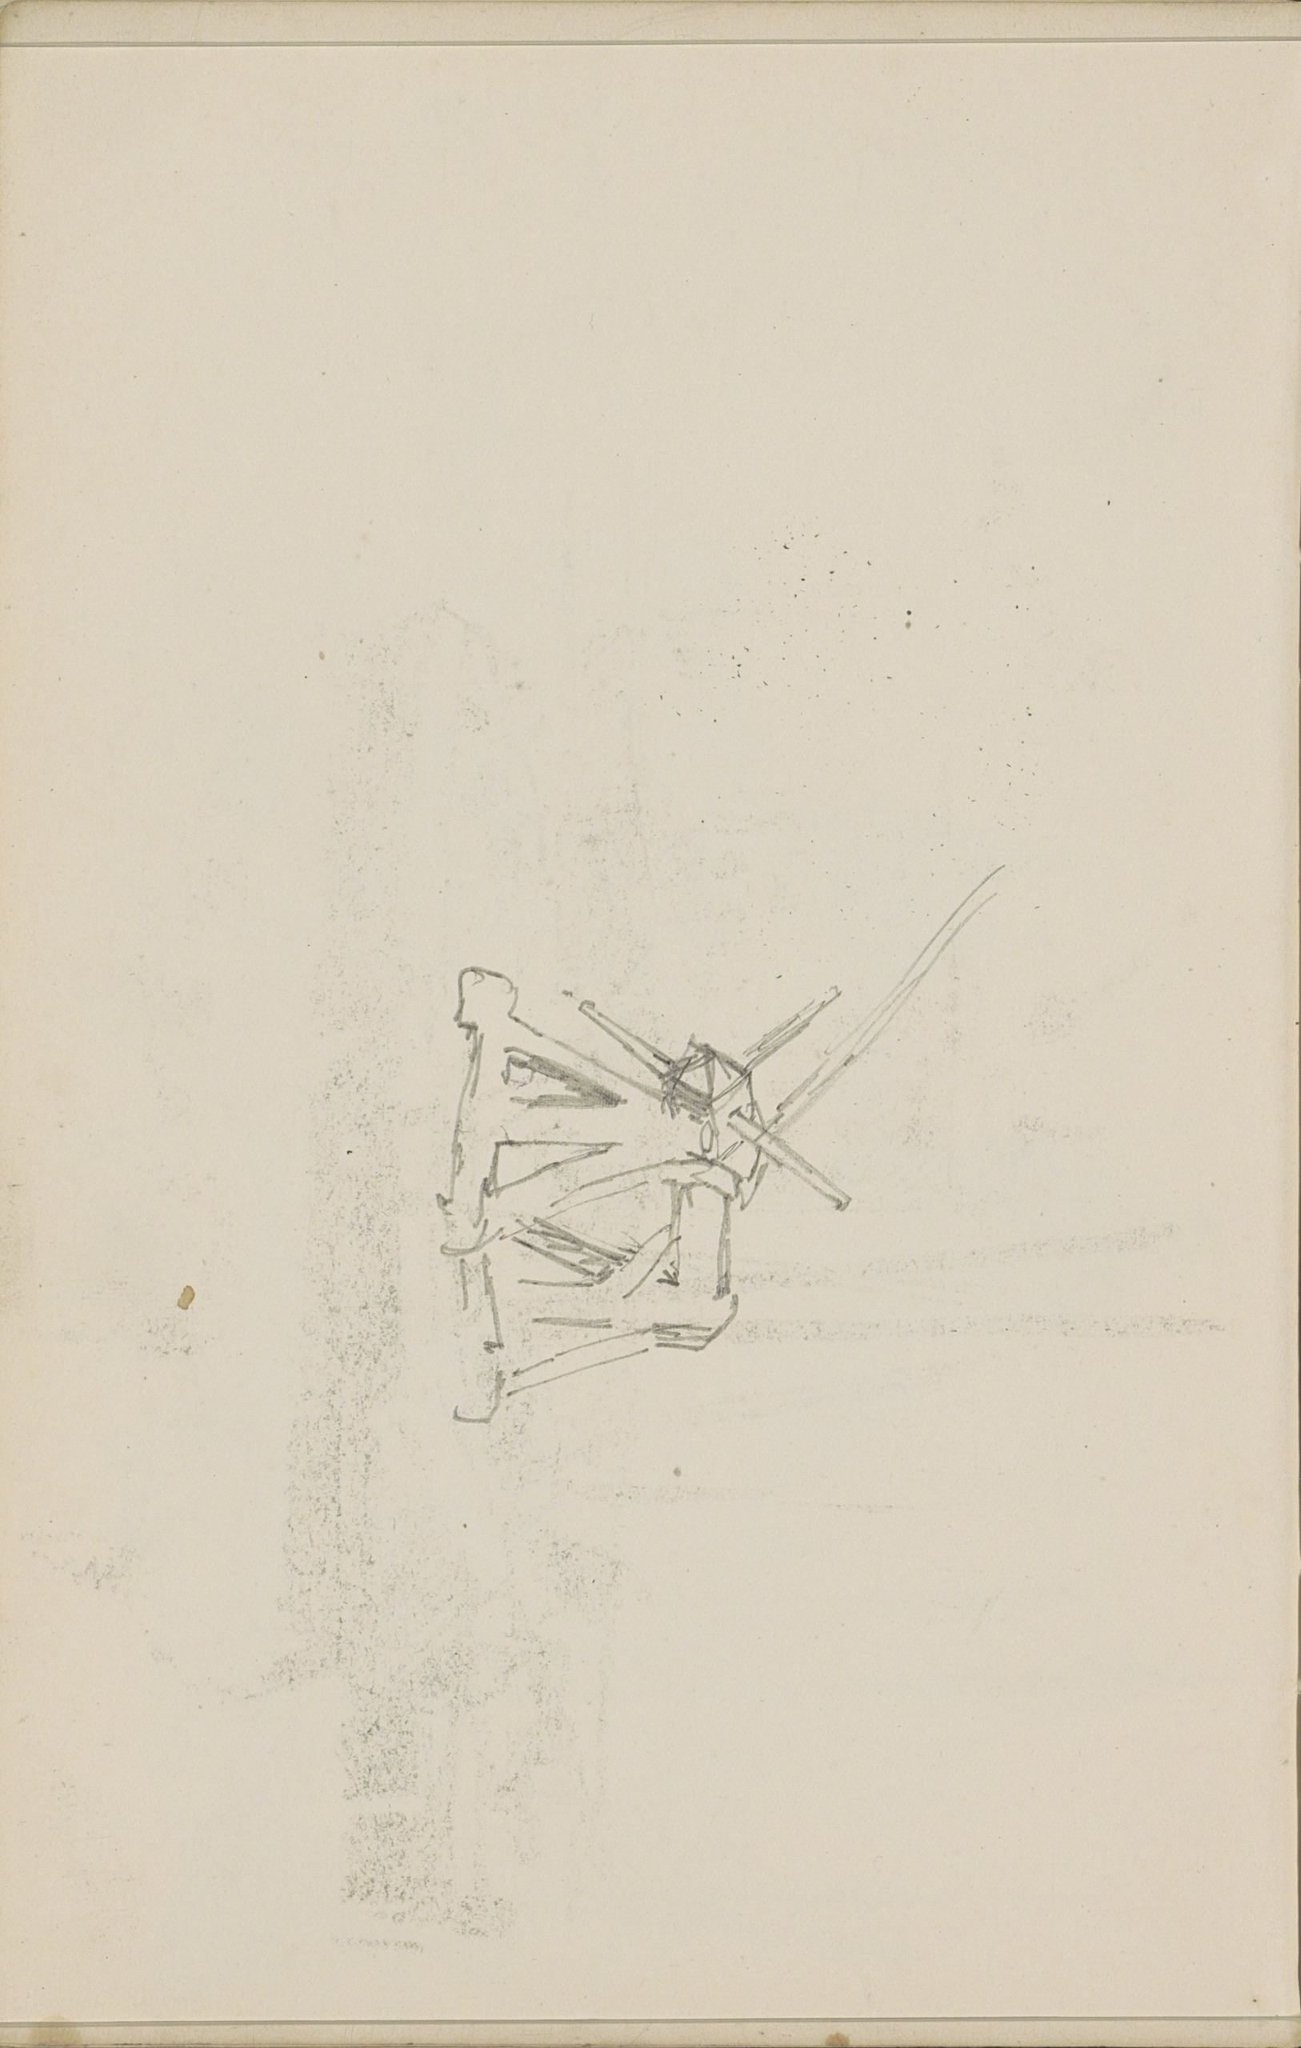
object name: sketchbook leaf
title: Werktuig om een sluis te bedienen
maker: cornelis vreedenburgh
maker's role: draughtsman, print maker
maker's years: 1880-1946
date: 1890-1946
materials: paper, pencil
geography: amsterdam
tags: lift-lock, canal lock (+ variant)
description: Blad 19 verso uit een schetsboek met 45 bladen.